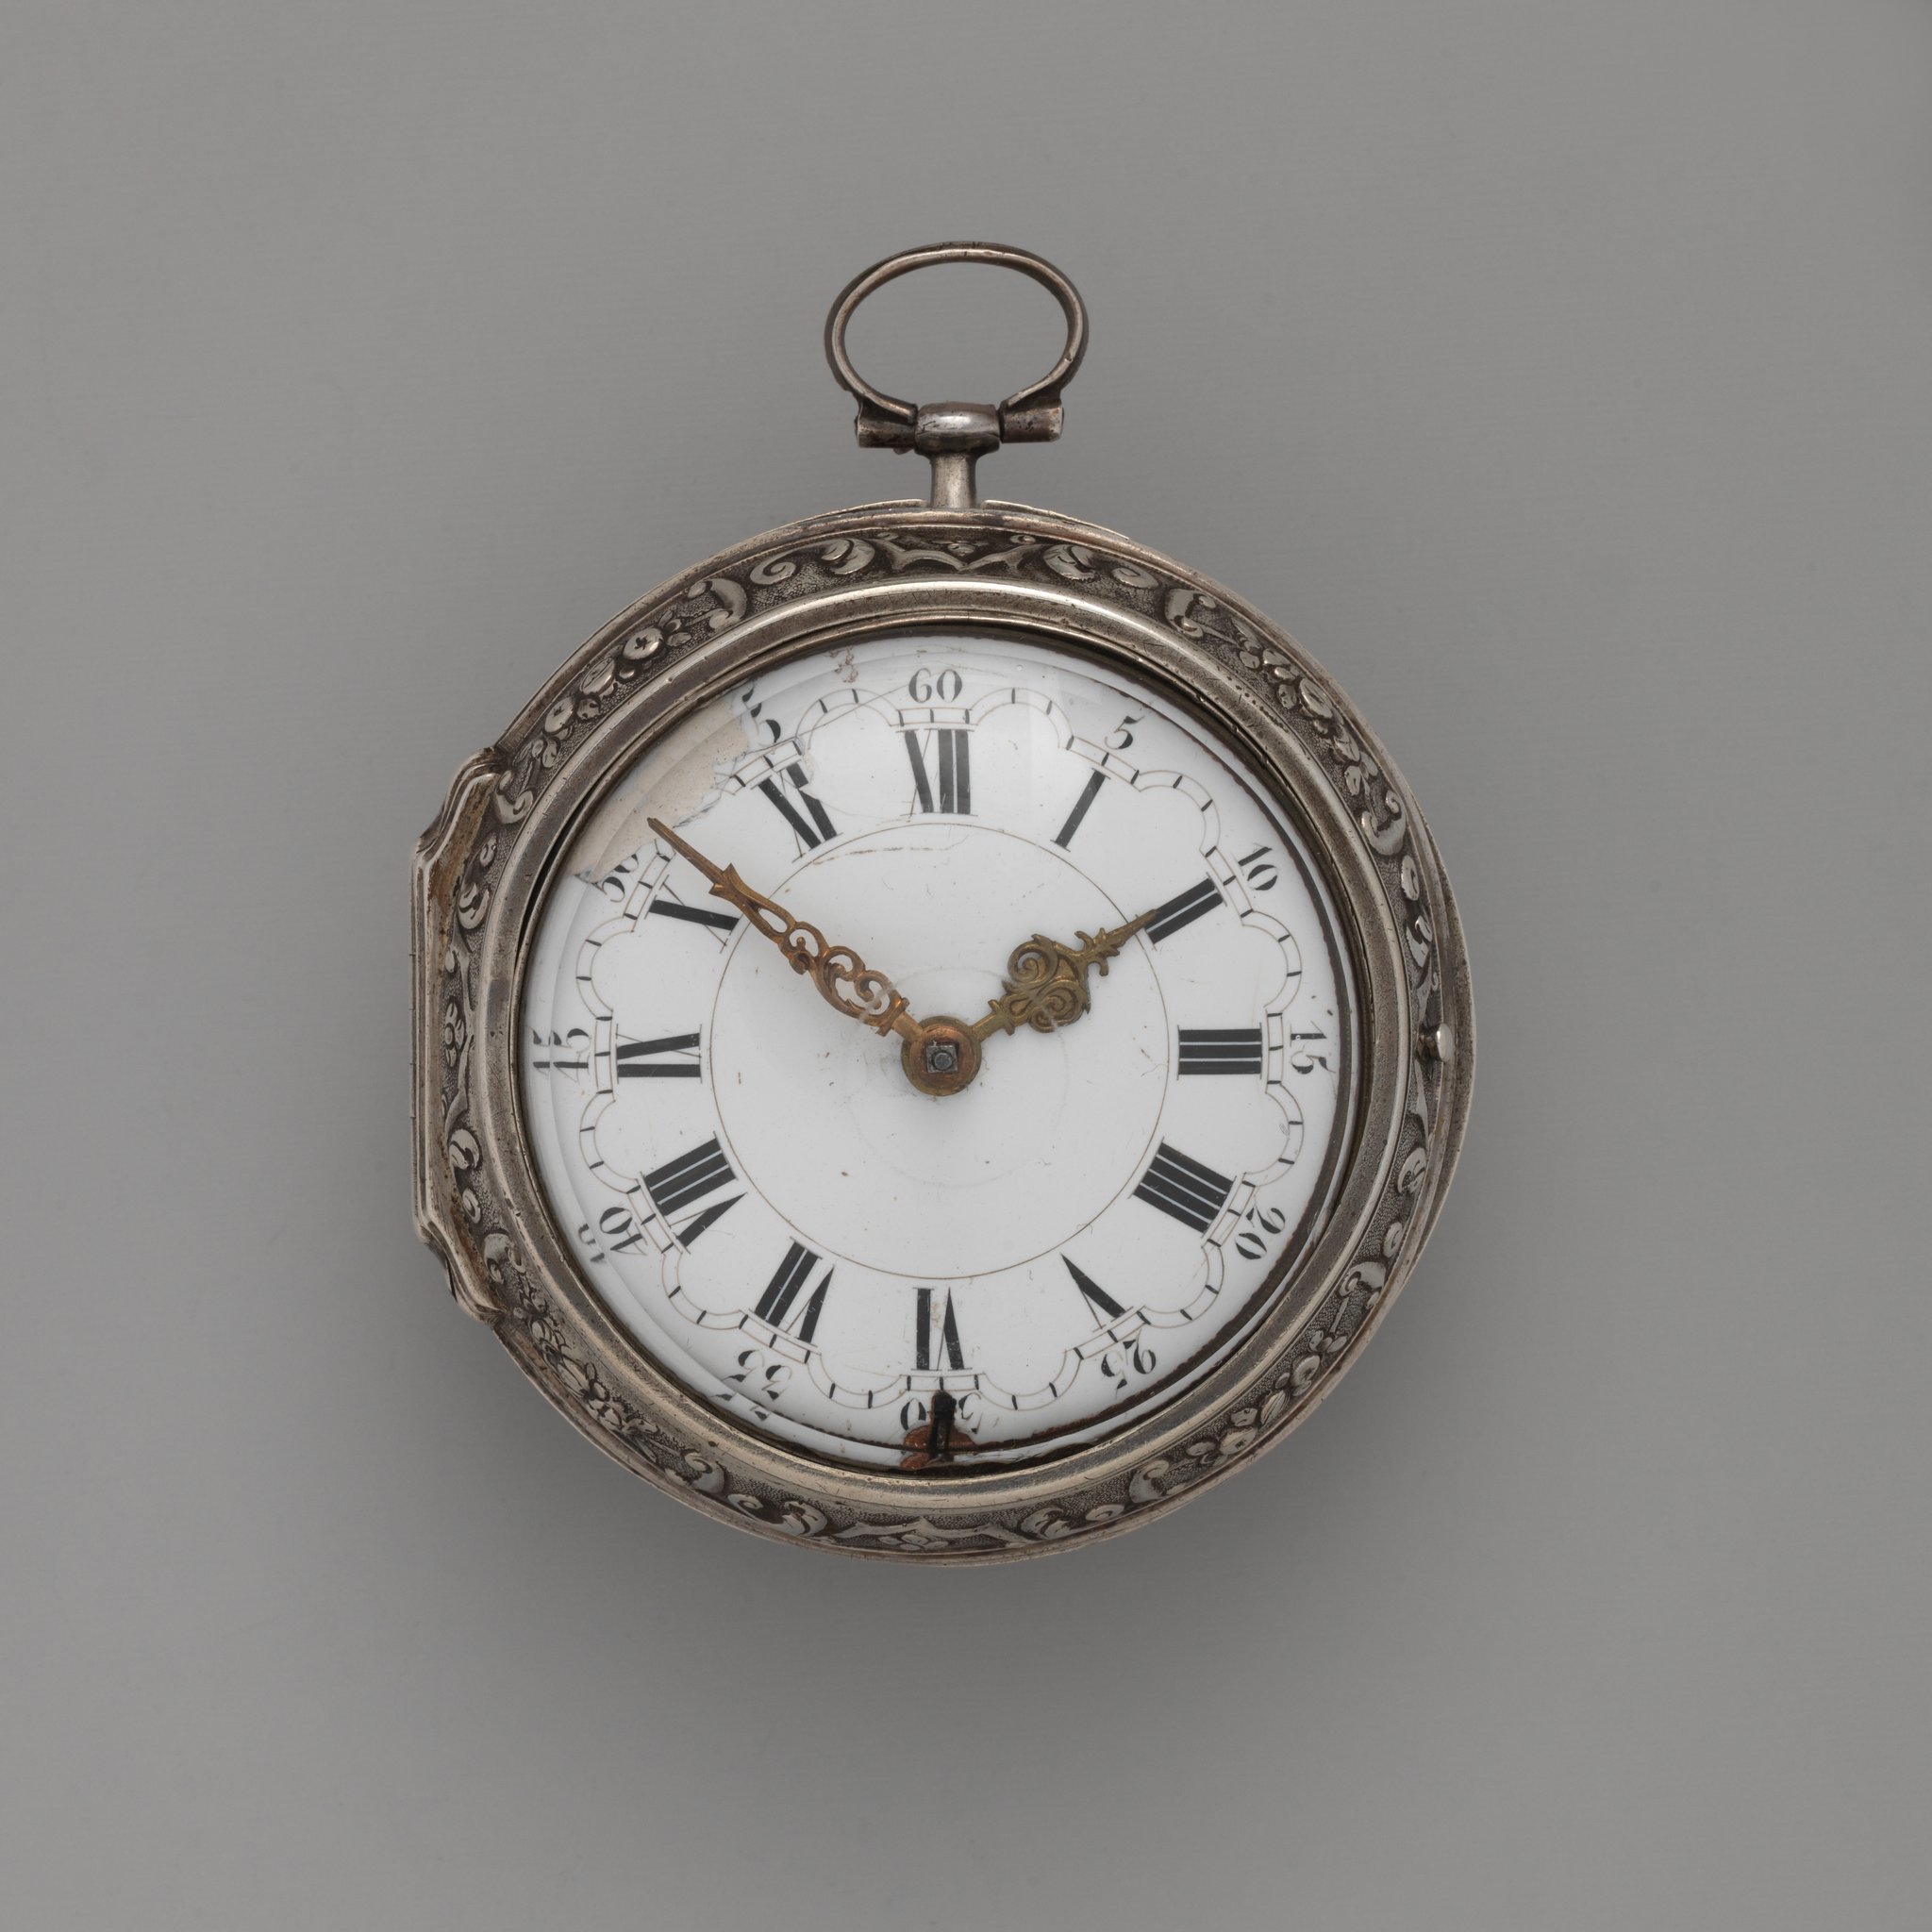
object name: watch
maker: john may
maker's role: maker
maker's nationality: british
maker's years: 1650-1715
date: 1700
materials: enamel, silver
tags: men,women